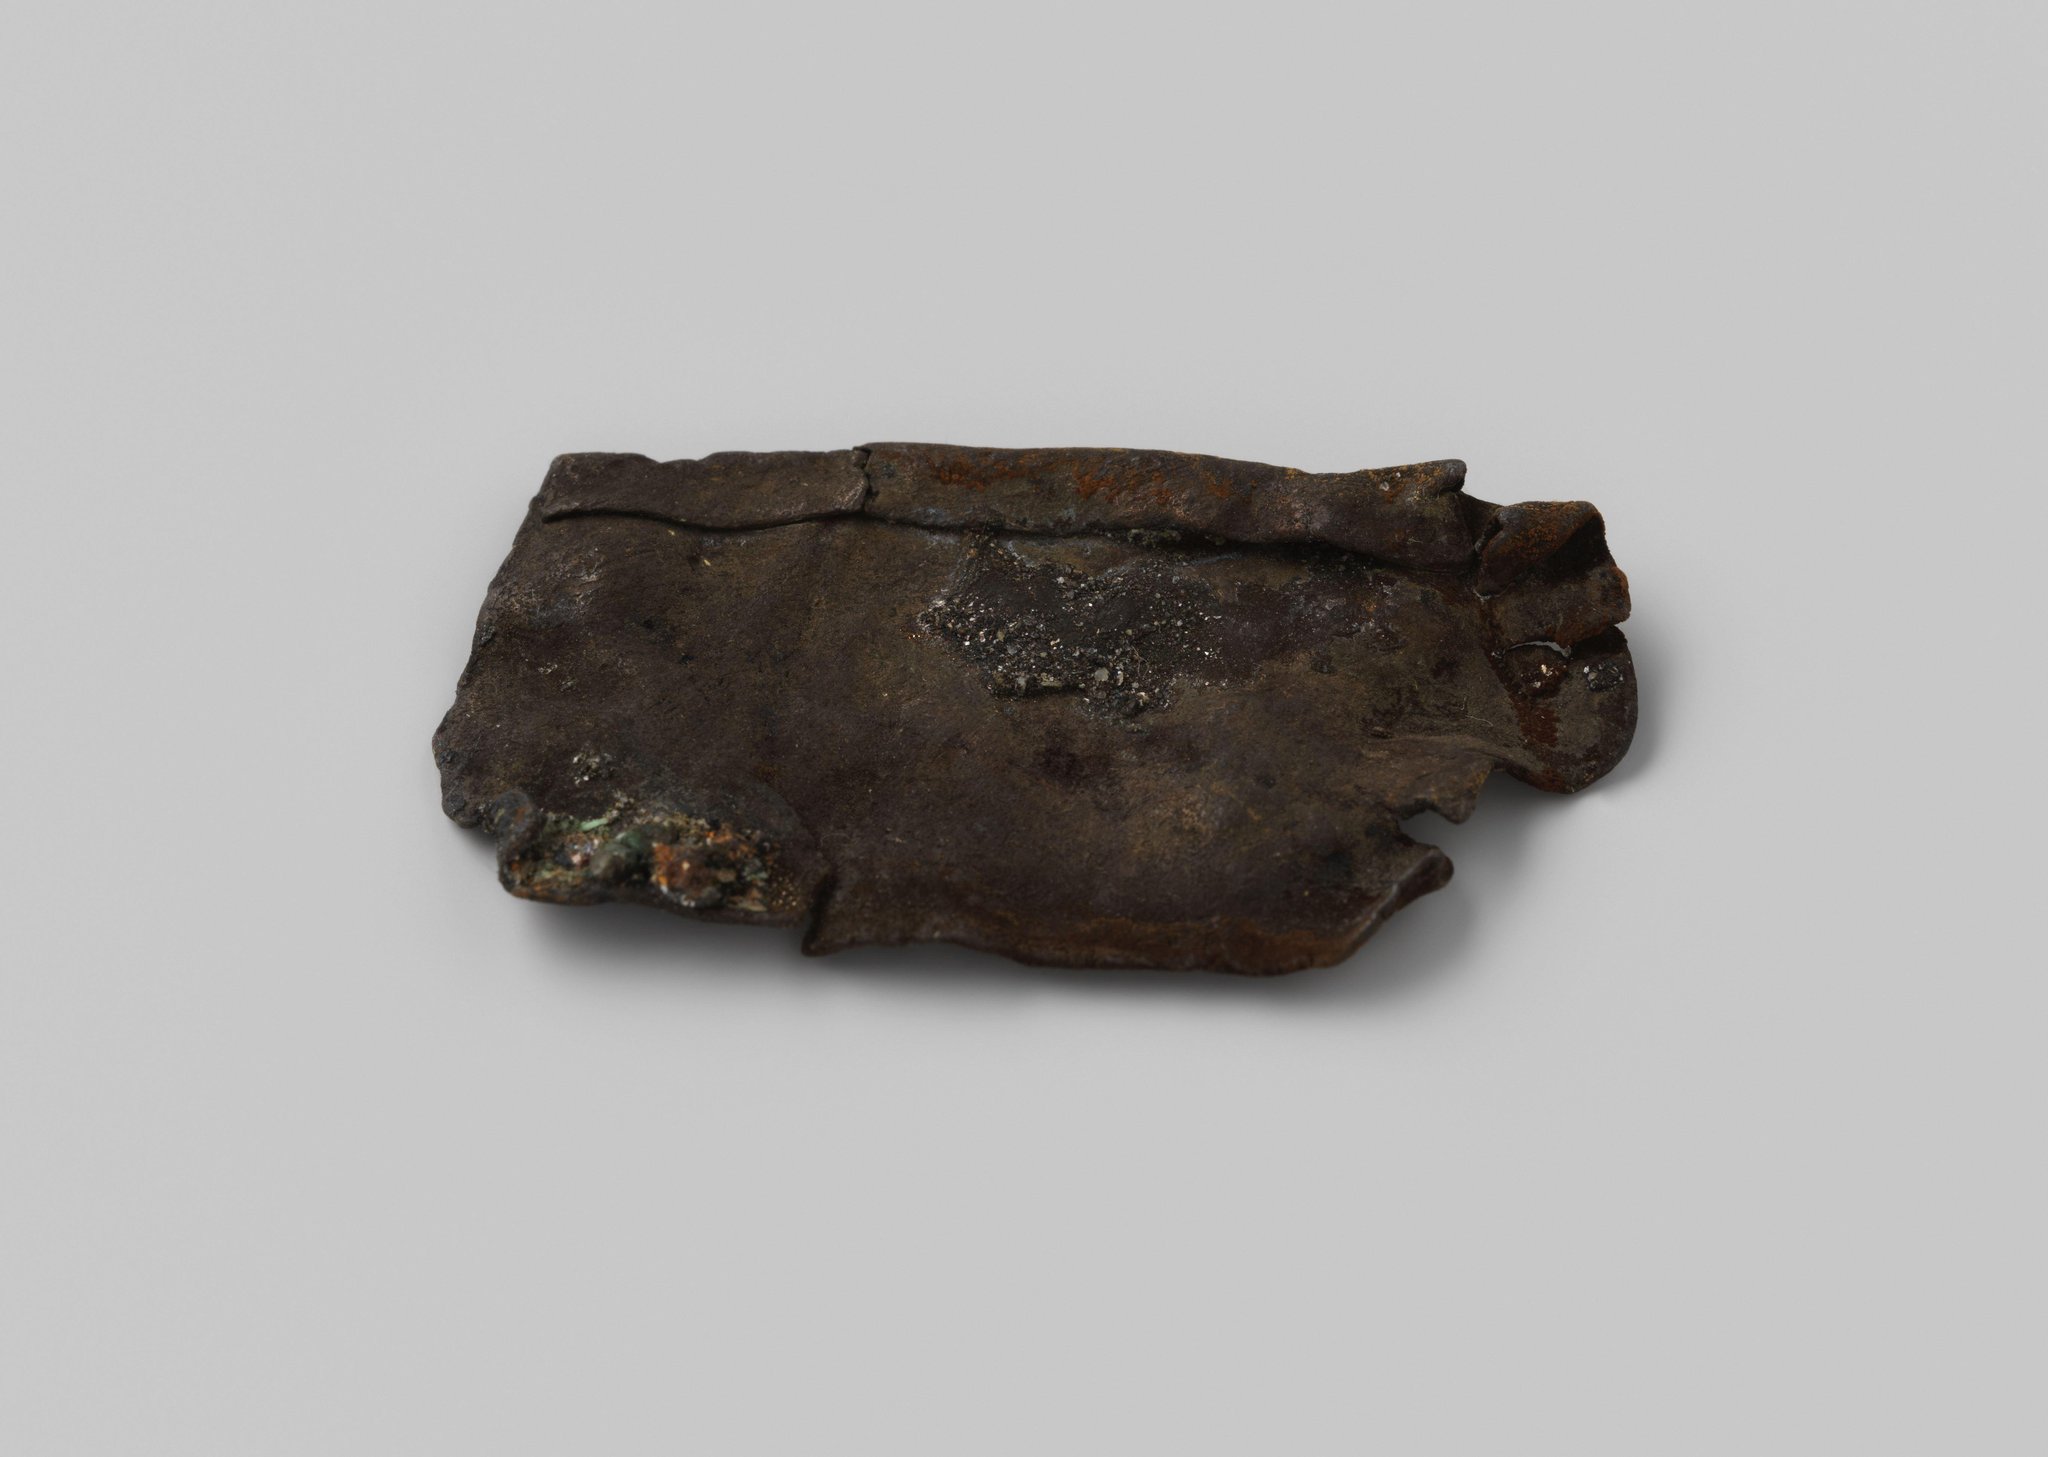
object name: fragment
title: Fragment plaatwerk uit het wrak van de Oost-Indiëvaarder Hollandia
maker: Anonymous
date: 1700-1743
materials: copper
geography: netherlands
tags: verenigde oostindische compagnie, hollandia (schip), annet